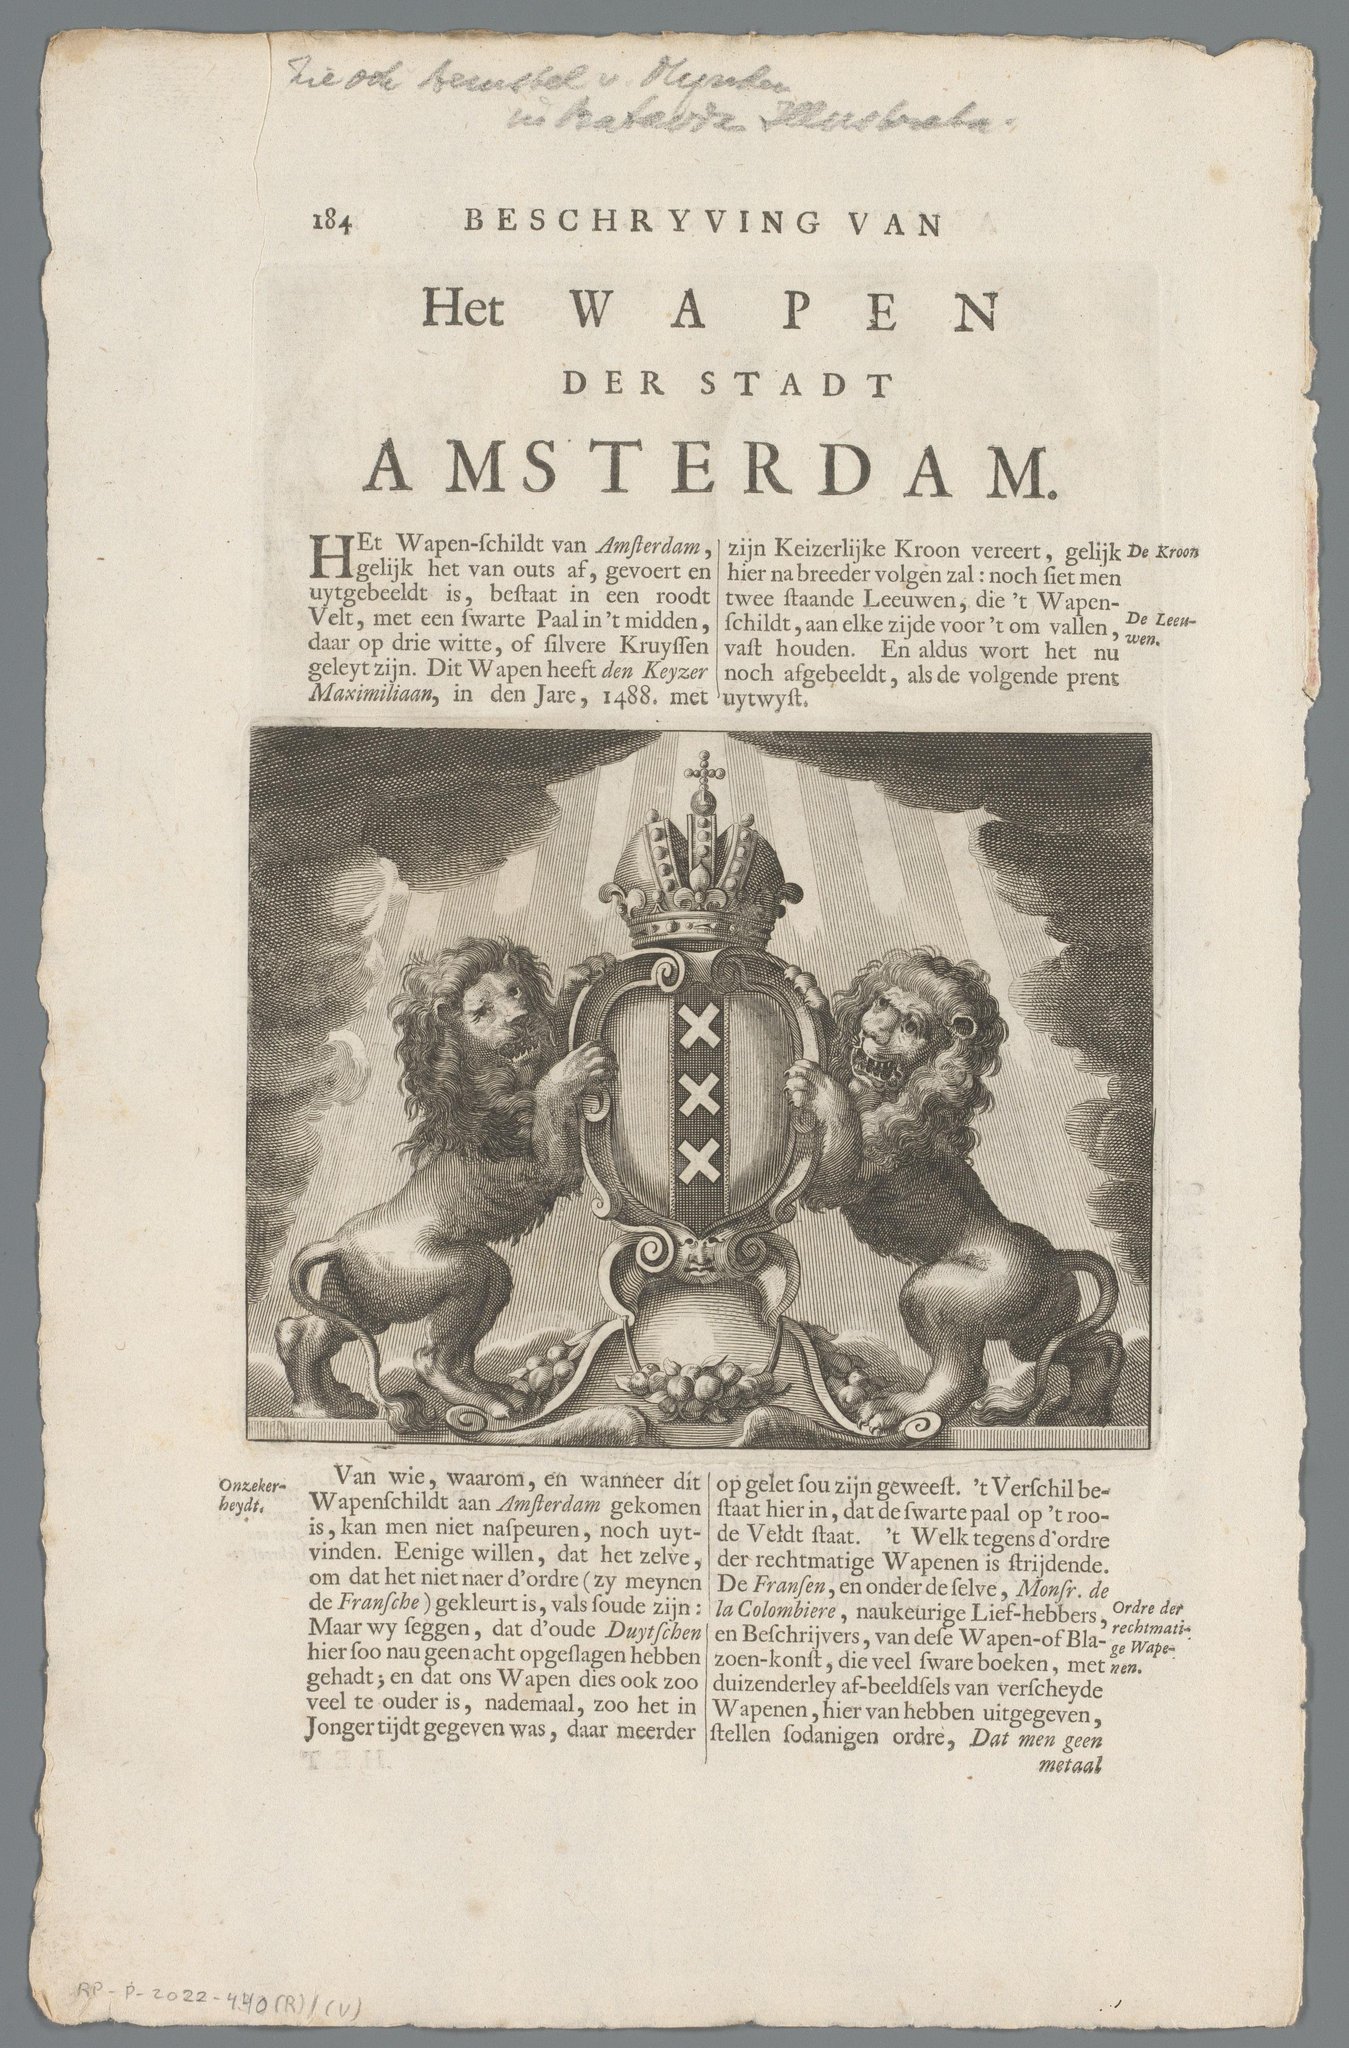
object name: print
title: Wapen van de stad Amsterdam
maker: Anonymous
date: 1693-1694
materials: paper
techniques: engraving, etching, letterpress printing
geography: amsterdam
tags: seal, stamp, amsterdam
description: Blad uit: Commelin, Casparus. Beschryvinge der stad Amsterdam. Amsterdam: Abraham Wolfgang, Gillis en Johannes Janssonius van Waesberge, weduwe Dirk en Hendrick Boom, Abraham van Someren en Rembertus Goethals, 1693. Prent ook gebruikt in de 1694-editie, met enkel een andere titelpagina, uitgegeven door de weduwe van Aart Dircksz. Oossaan.